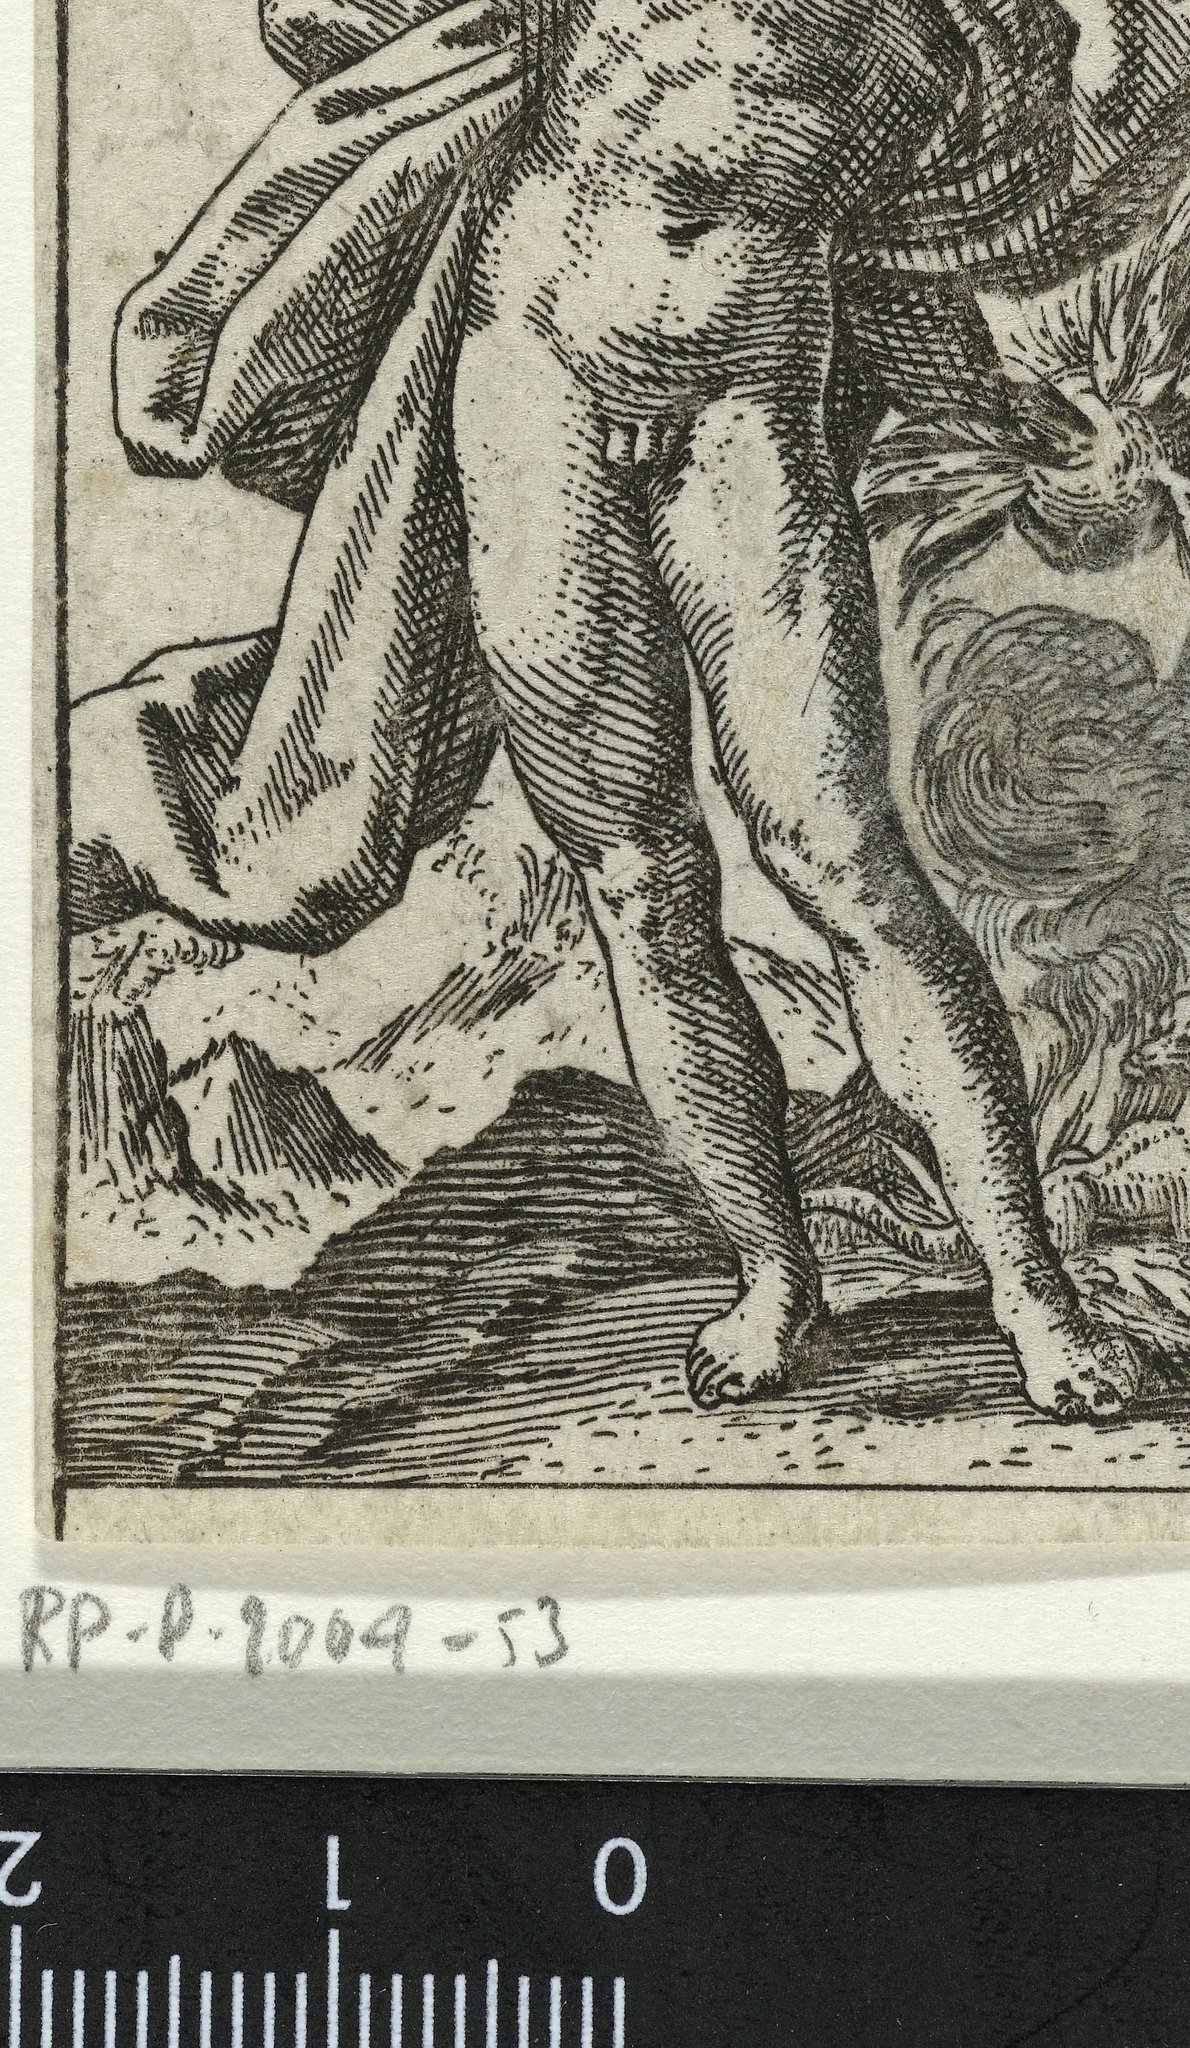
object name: print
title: Ignis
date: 1606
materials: paper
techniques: etching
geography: amsterdam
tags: fire (one of the four elements)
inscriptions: collector's mark: Lugt 2760, collector's mark: Lugt 2228, title: ‘IGNIS’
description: Personificatie van vuur, een van de vier elementen, als een naakte jongeman met een bundel vuur in de hand.